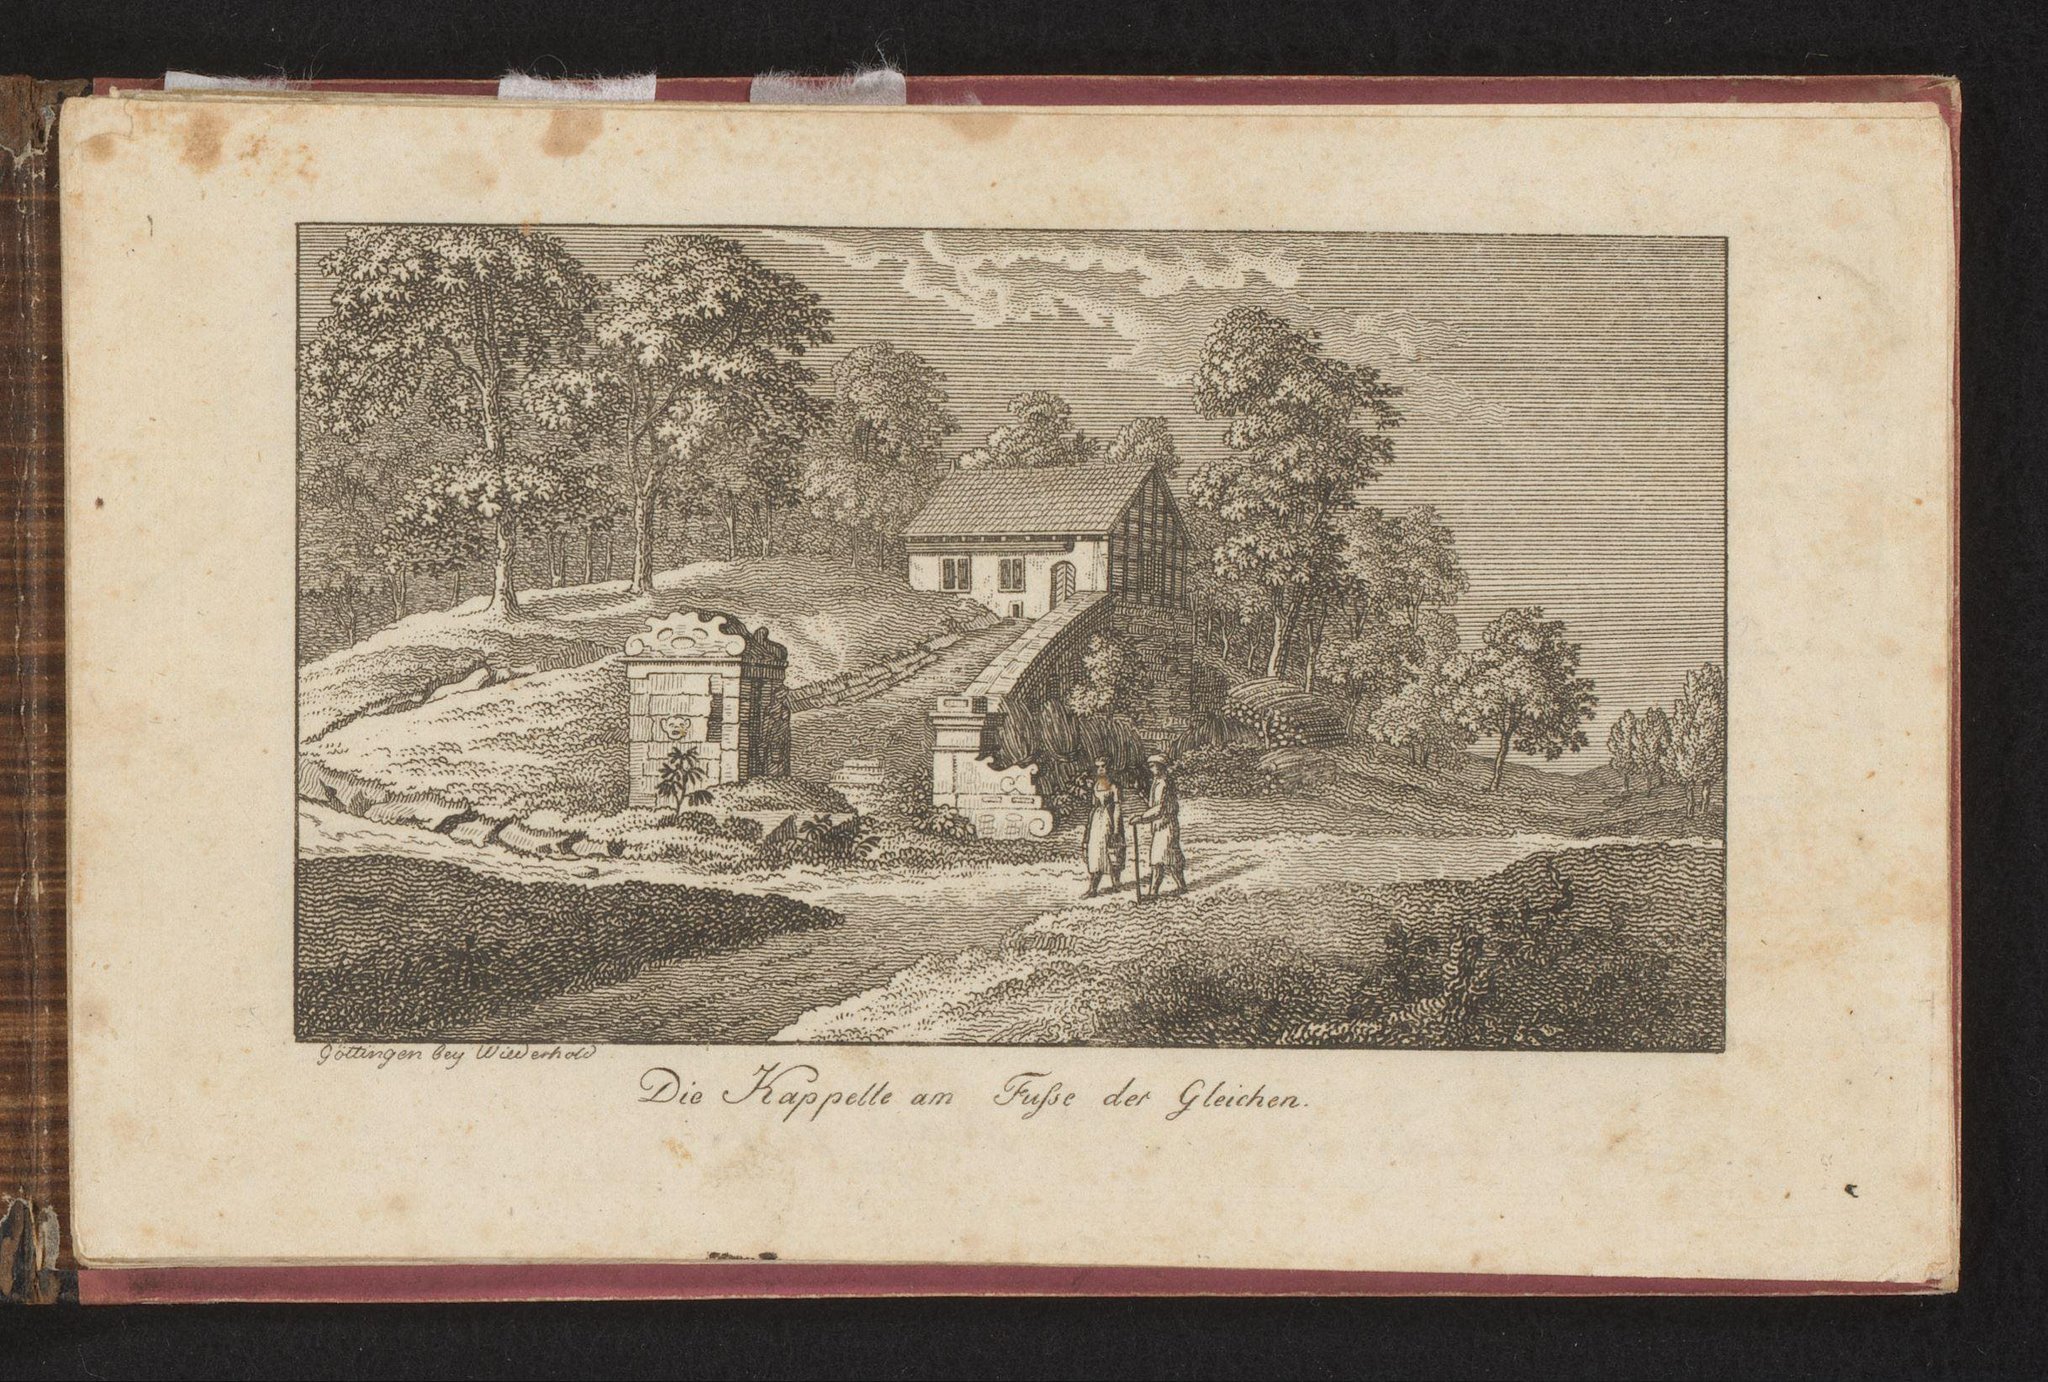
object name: print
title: Gezicht op een kapel bij Gleichen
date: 1770-1817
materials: ink, paper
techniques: etching, writing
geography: gottingen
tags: 'album amicorum', 'stammbuch', low hill country (+ landscape with figures, staffage), church (exterior) - qq - small church, chapel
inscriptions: tekst, verso, handgeschreven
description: Handgeschreven tekst in het Duits op het verso.